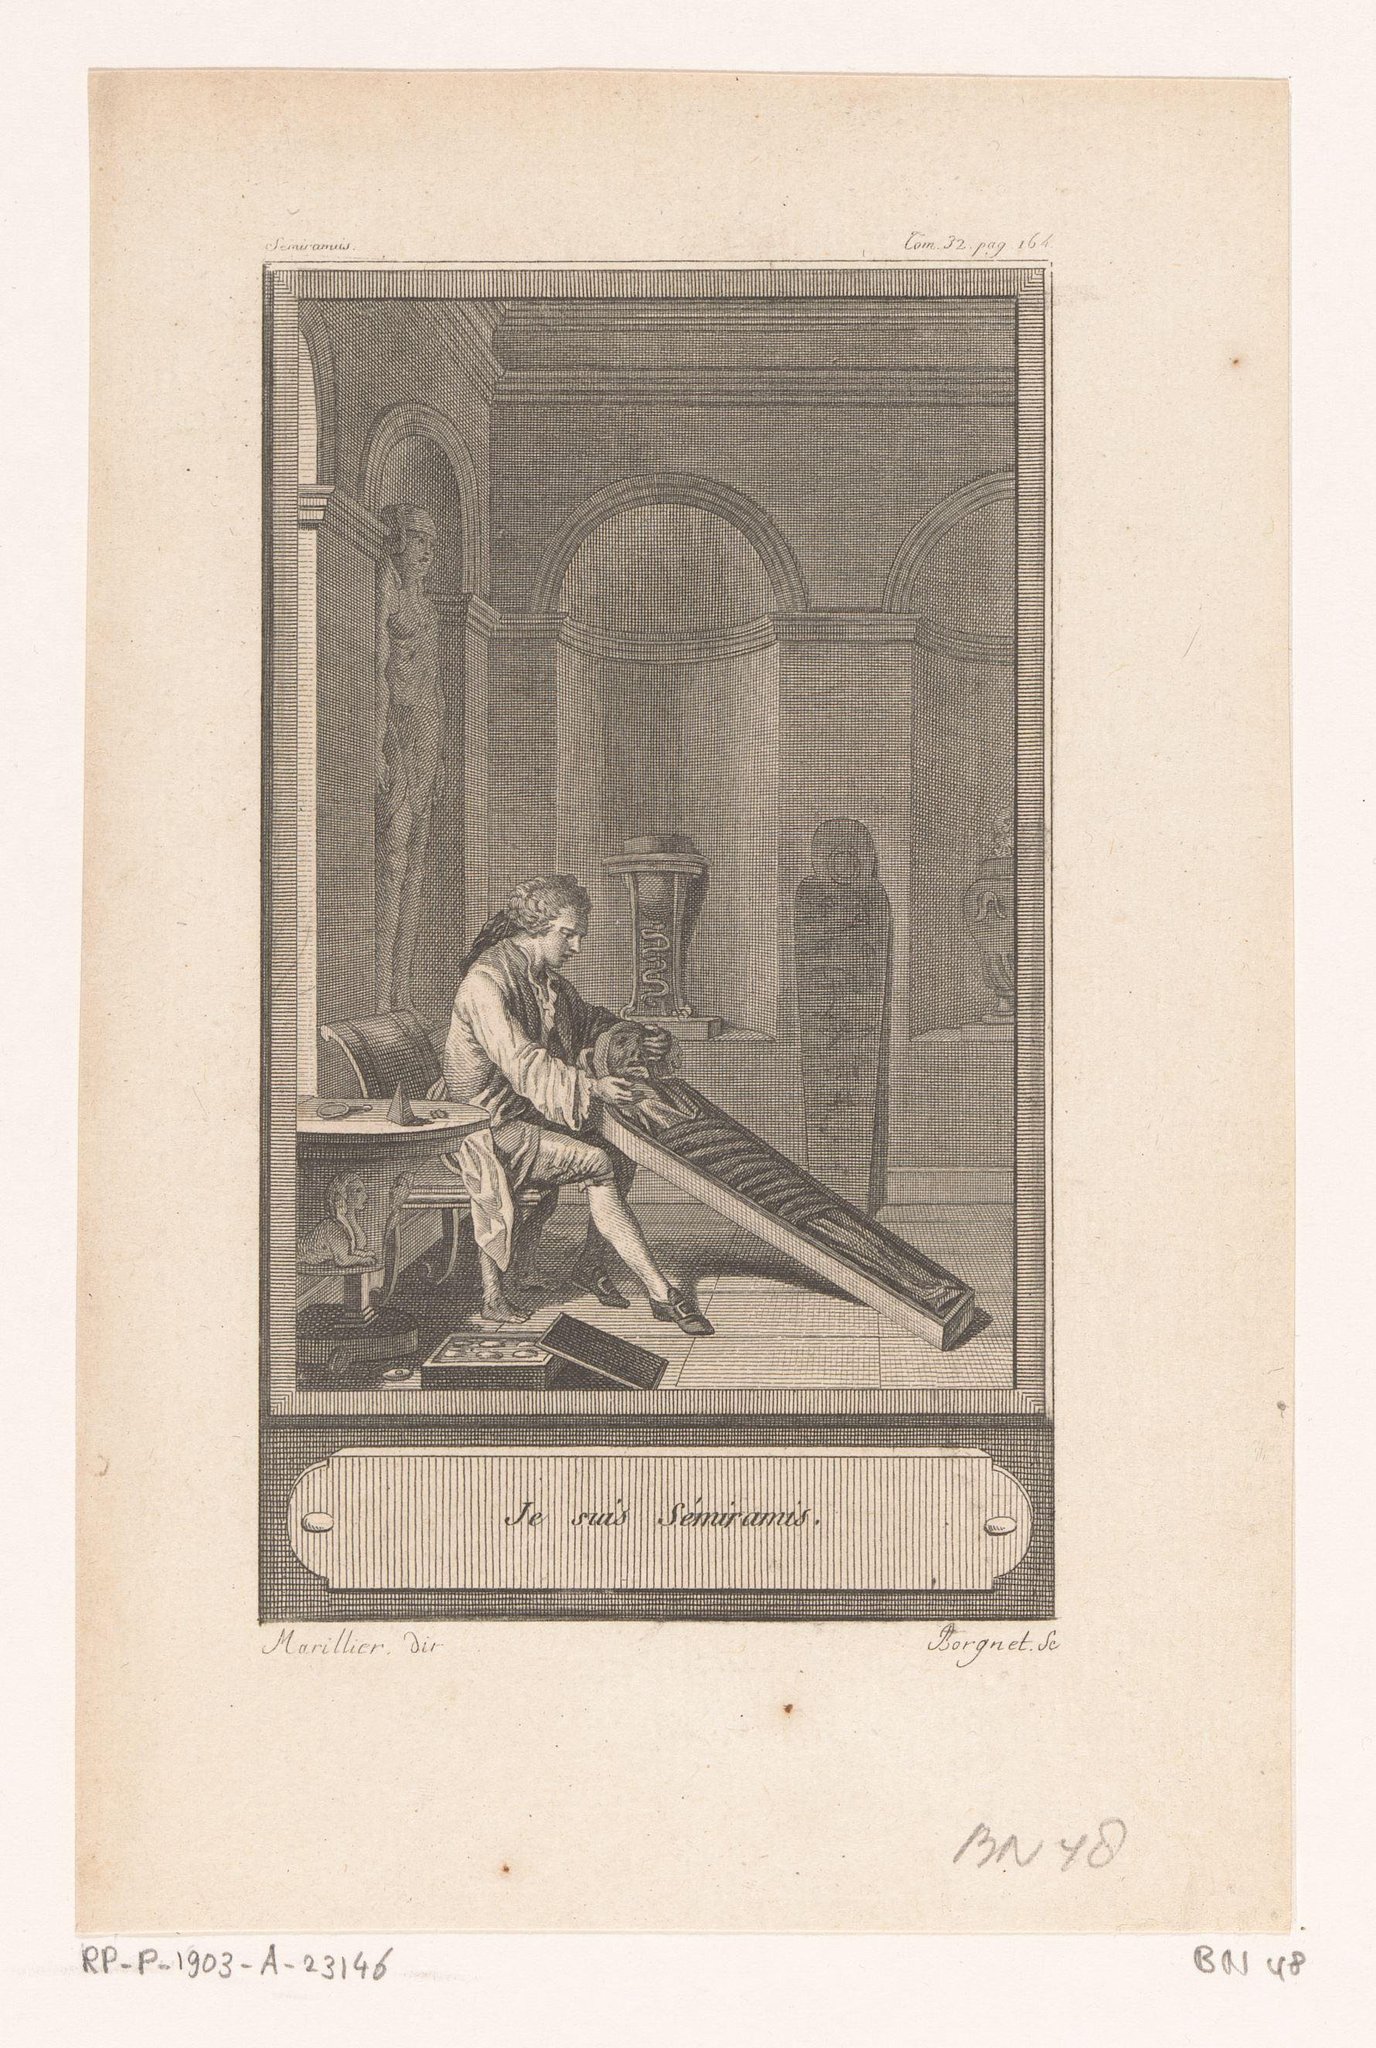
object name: print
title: Zittende man met een mummie in een sarcofaag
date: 1788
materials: paper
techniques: etching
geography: paris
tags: (story of) queen semiramis, mummy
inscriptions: collector's mark: Lugt 2228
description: Man zittend op een stoel met in zijn handen een sarcofaag met een mummie. Om hem heen staan in het vertrek verschillende Egyptische objecten.